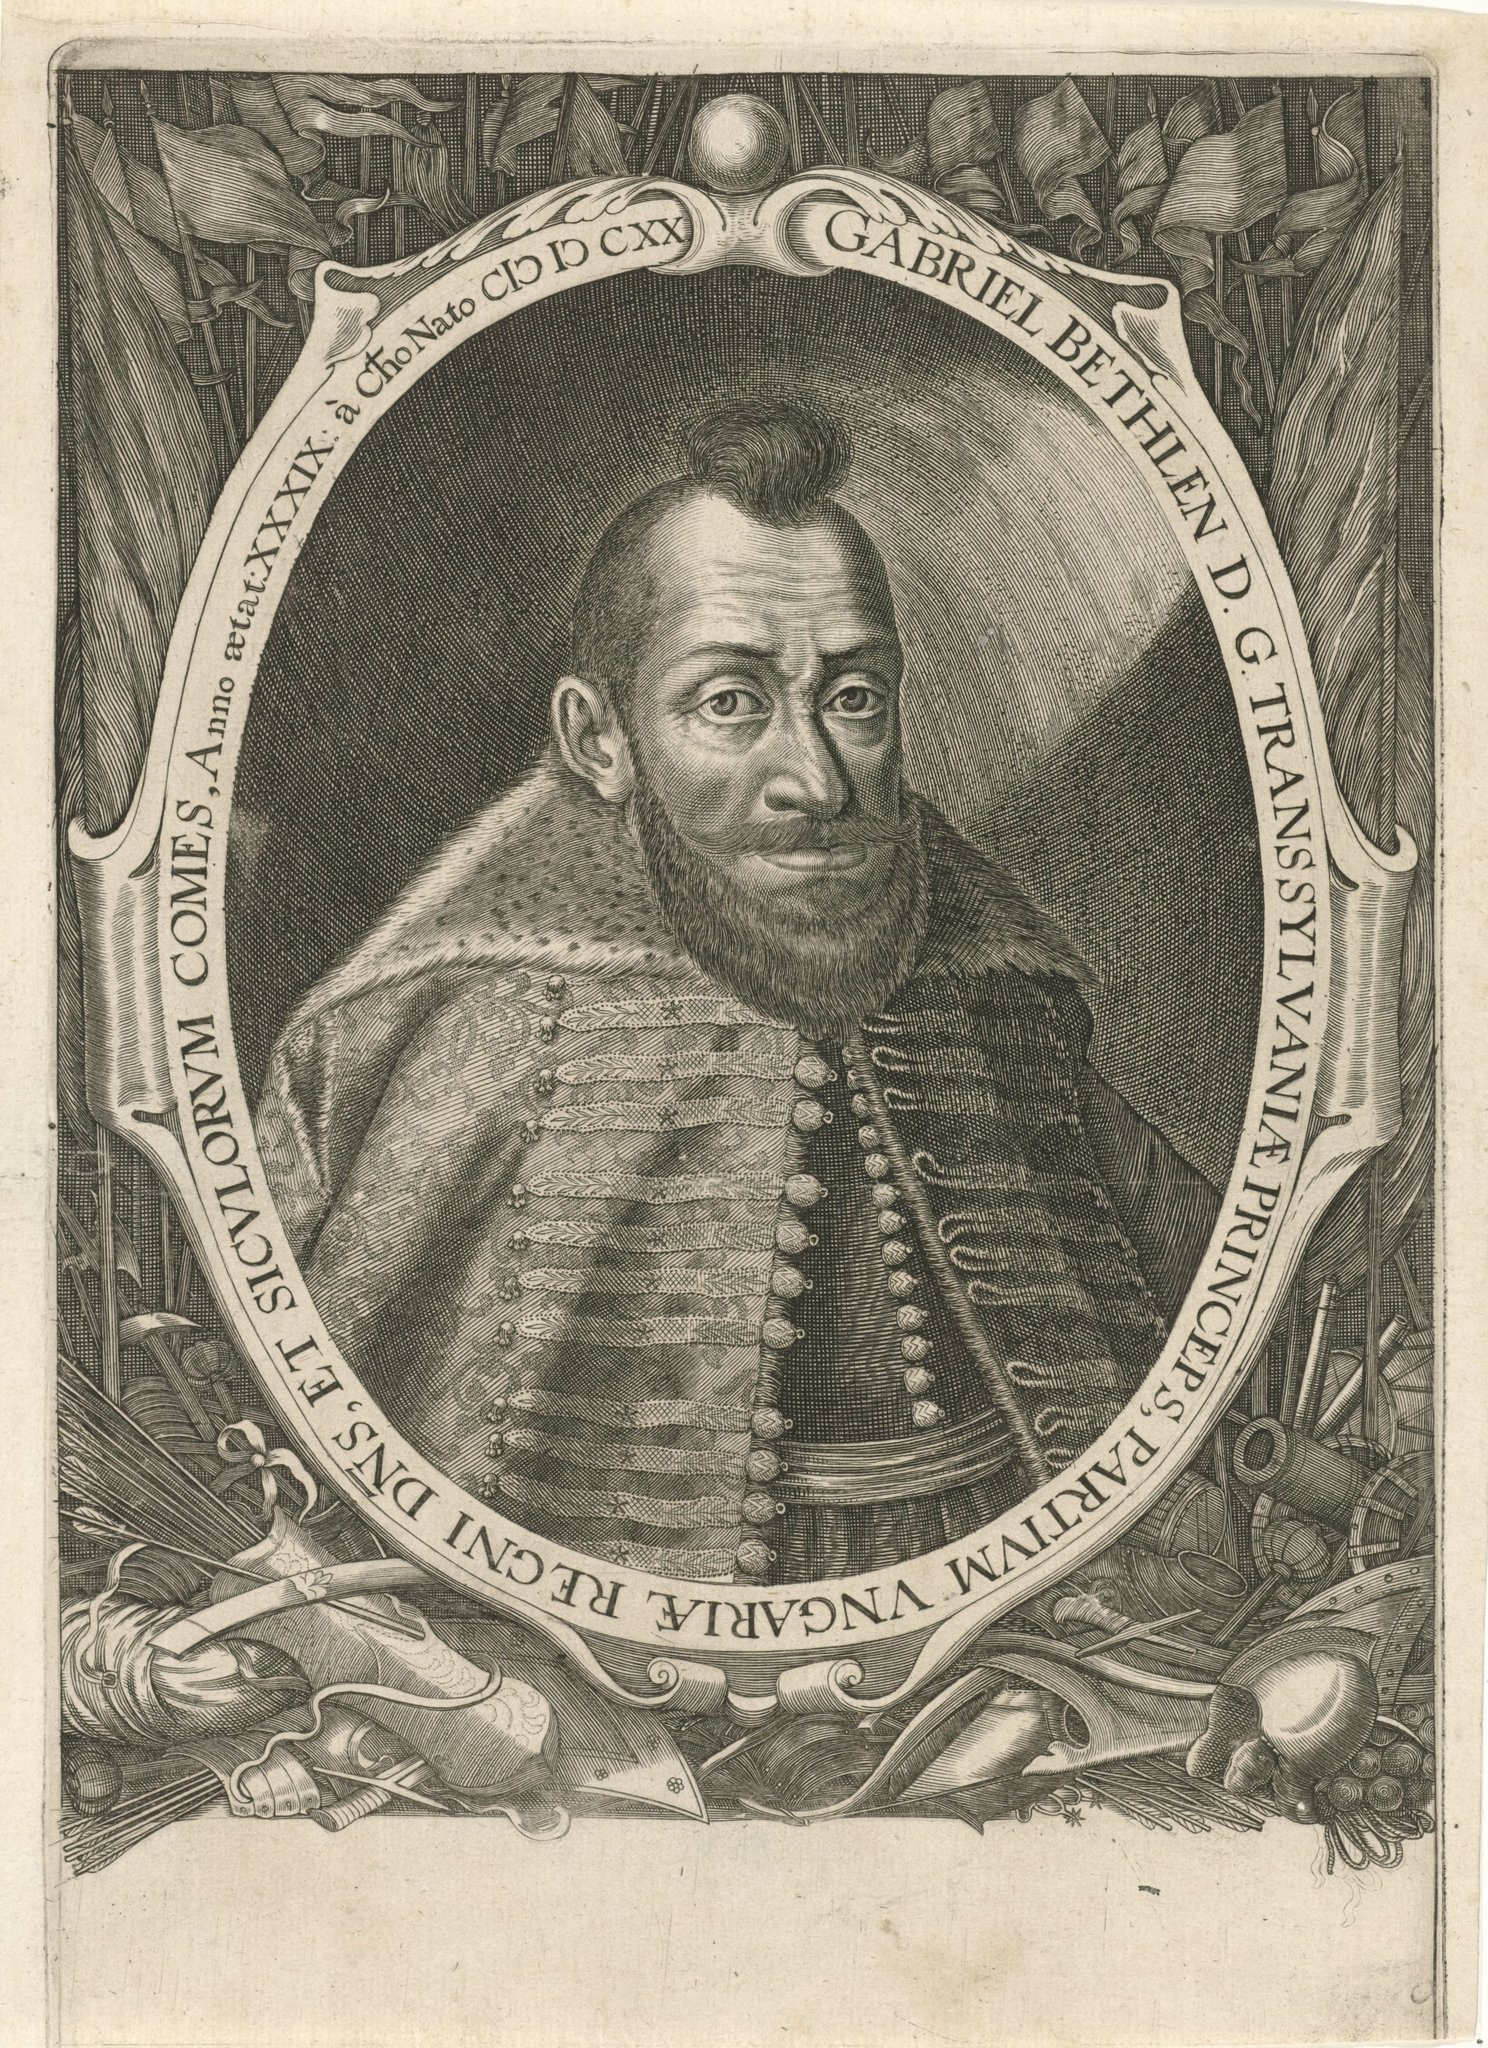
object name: print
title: Portret van Gabriel Bethlen, prins van Transsylvanië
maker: aegidius sadeler (ii)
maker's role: draughtsman, print maker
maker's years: 1568-1629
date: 1620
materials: paper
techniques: engraving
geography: prague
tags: prins, gabriël bethlen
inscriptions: collector's mark: Lugt 2760, collector's mark: Lugt 2228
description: Portret van Gabriel Bethlen, prins van Transsylvanië op 39-jarige leeftijd. Rondom het portret wapentuig.